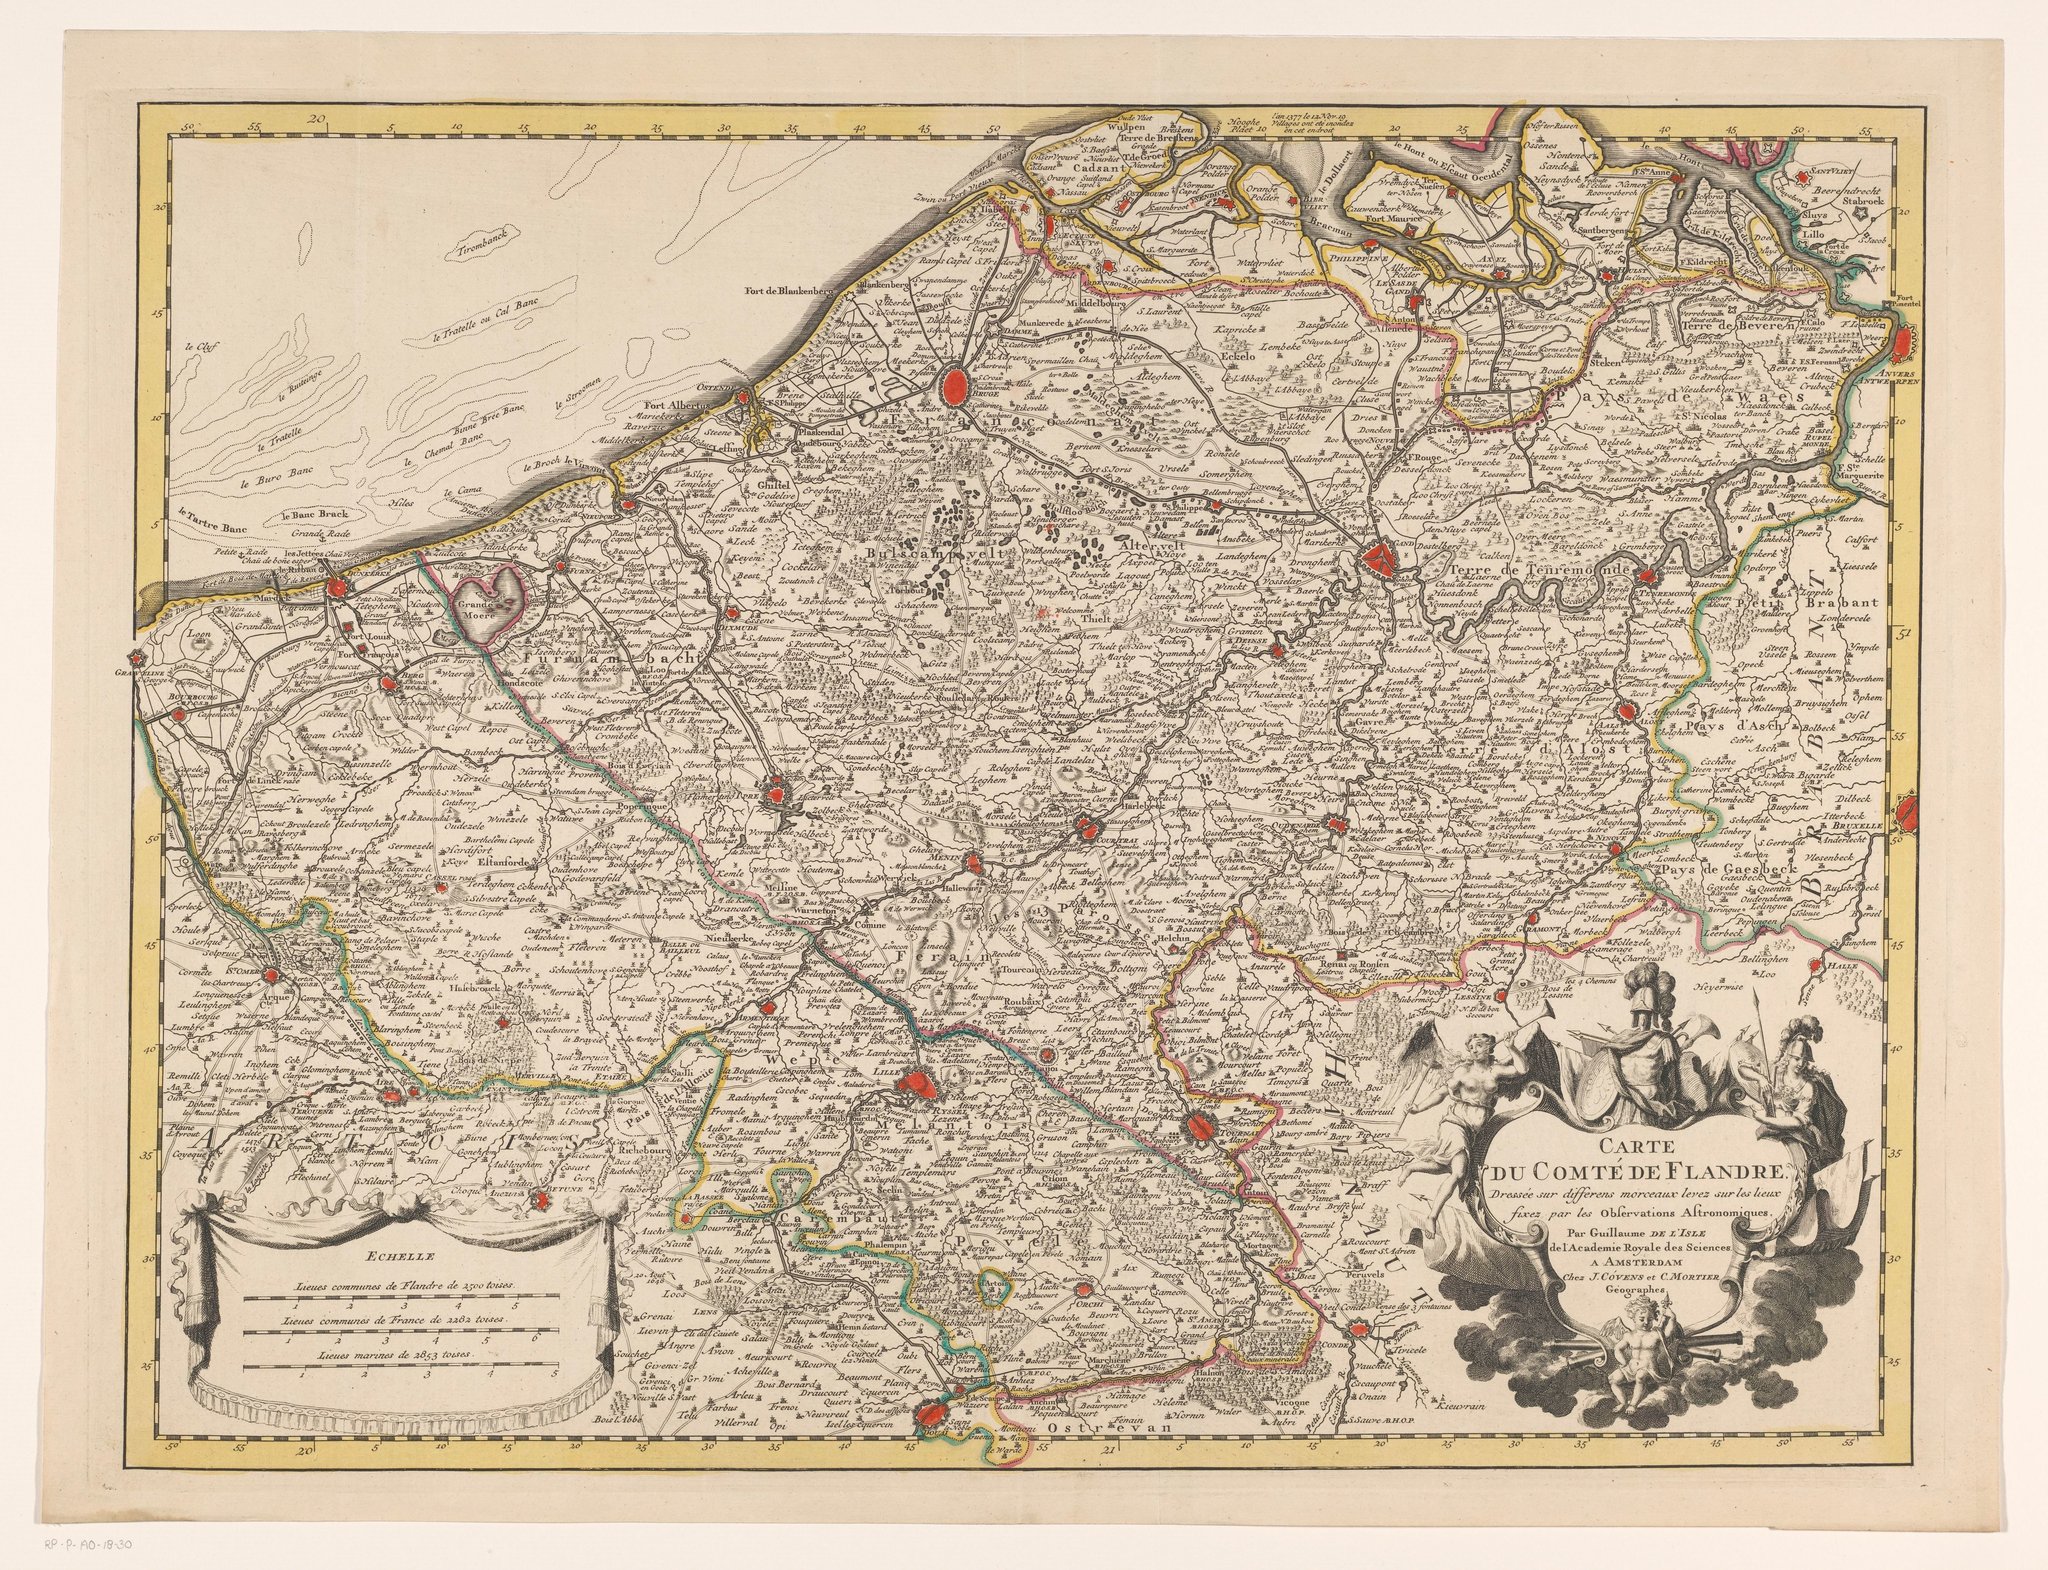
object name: map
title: Kaart van het graafschap Vlaanderen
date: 1721-1774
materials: paper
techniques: engraving, etching, hand coloring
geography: paris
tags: maps of separate countries or regions, (story of) minerva (pallas, athena), fame; 'fama', 'fama buona', 'fama chiara' (ripa)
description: Kaart van het graafschap Vlaanderen. Rechtsonder de titelcartouche met links een personificatie van Faam en rechts Minerva. Linksonder een cartouche met drie schaalstokken: Lieues communes d Flandre de 2500 toises / Lieues communes de France de 2282 toises / Lieues marines de 2853 toises. De kaart is voorzien van een gradenverdeling langs de randen.